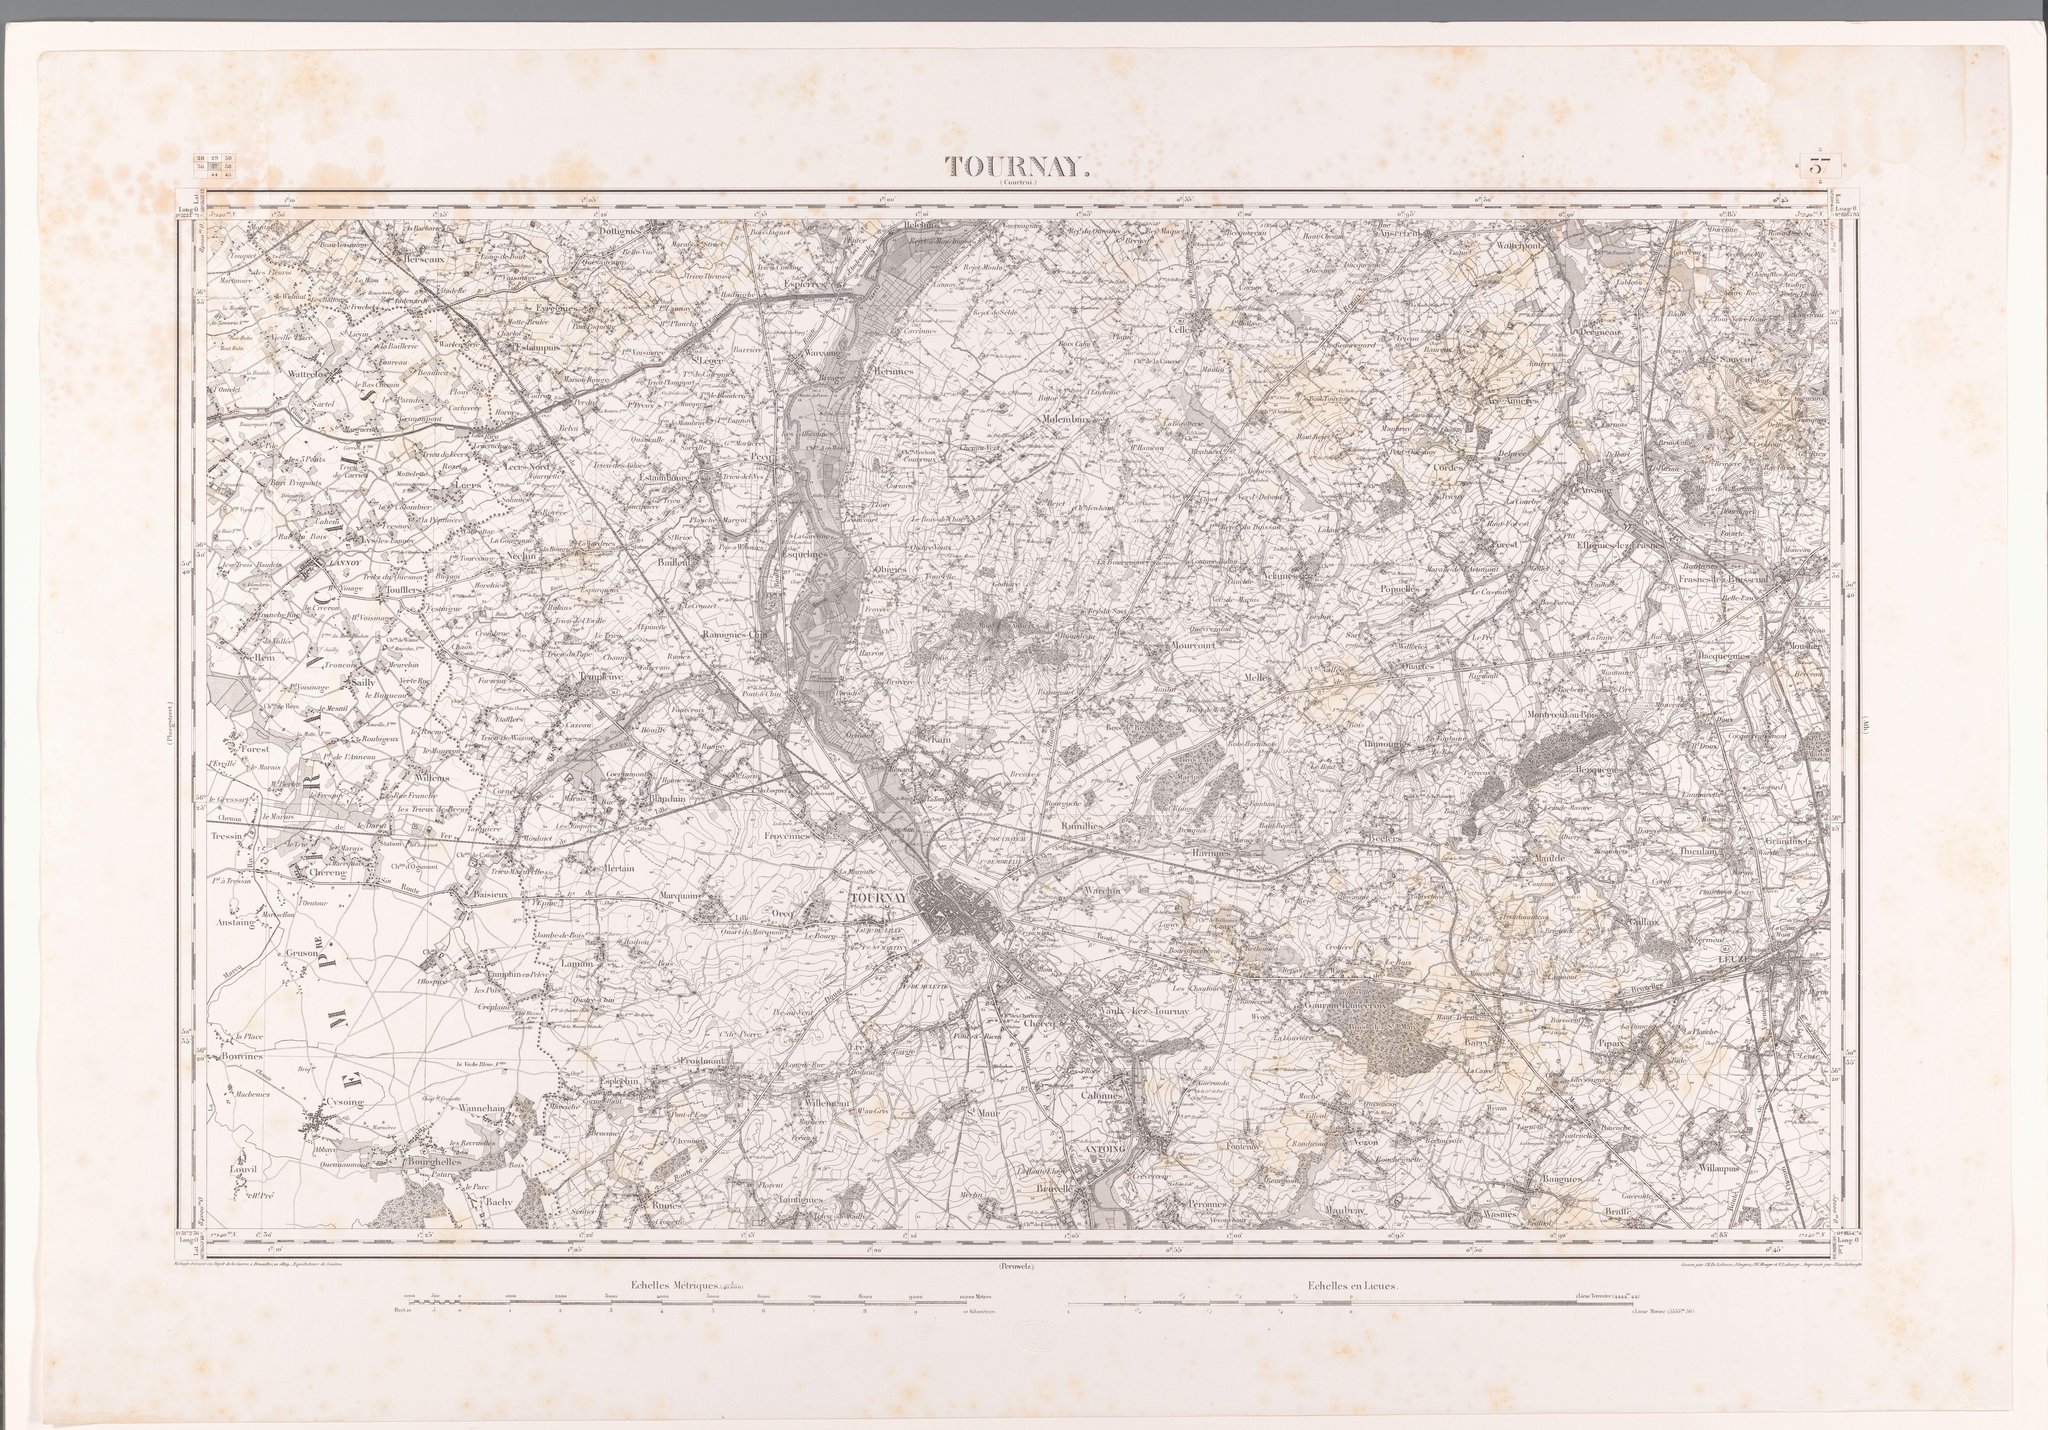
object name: map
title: Tournay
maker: j. vanderborght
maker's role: printer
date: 1869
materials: paper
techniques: lithograph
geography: brussels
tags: maps of separate countries or regions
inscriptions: check stamp: ‘Depot de la Guerre Belgique’